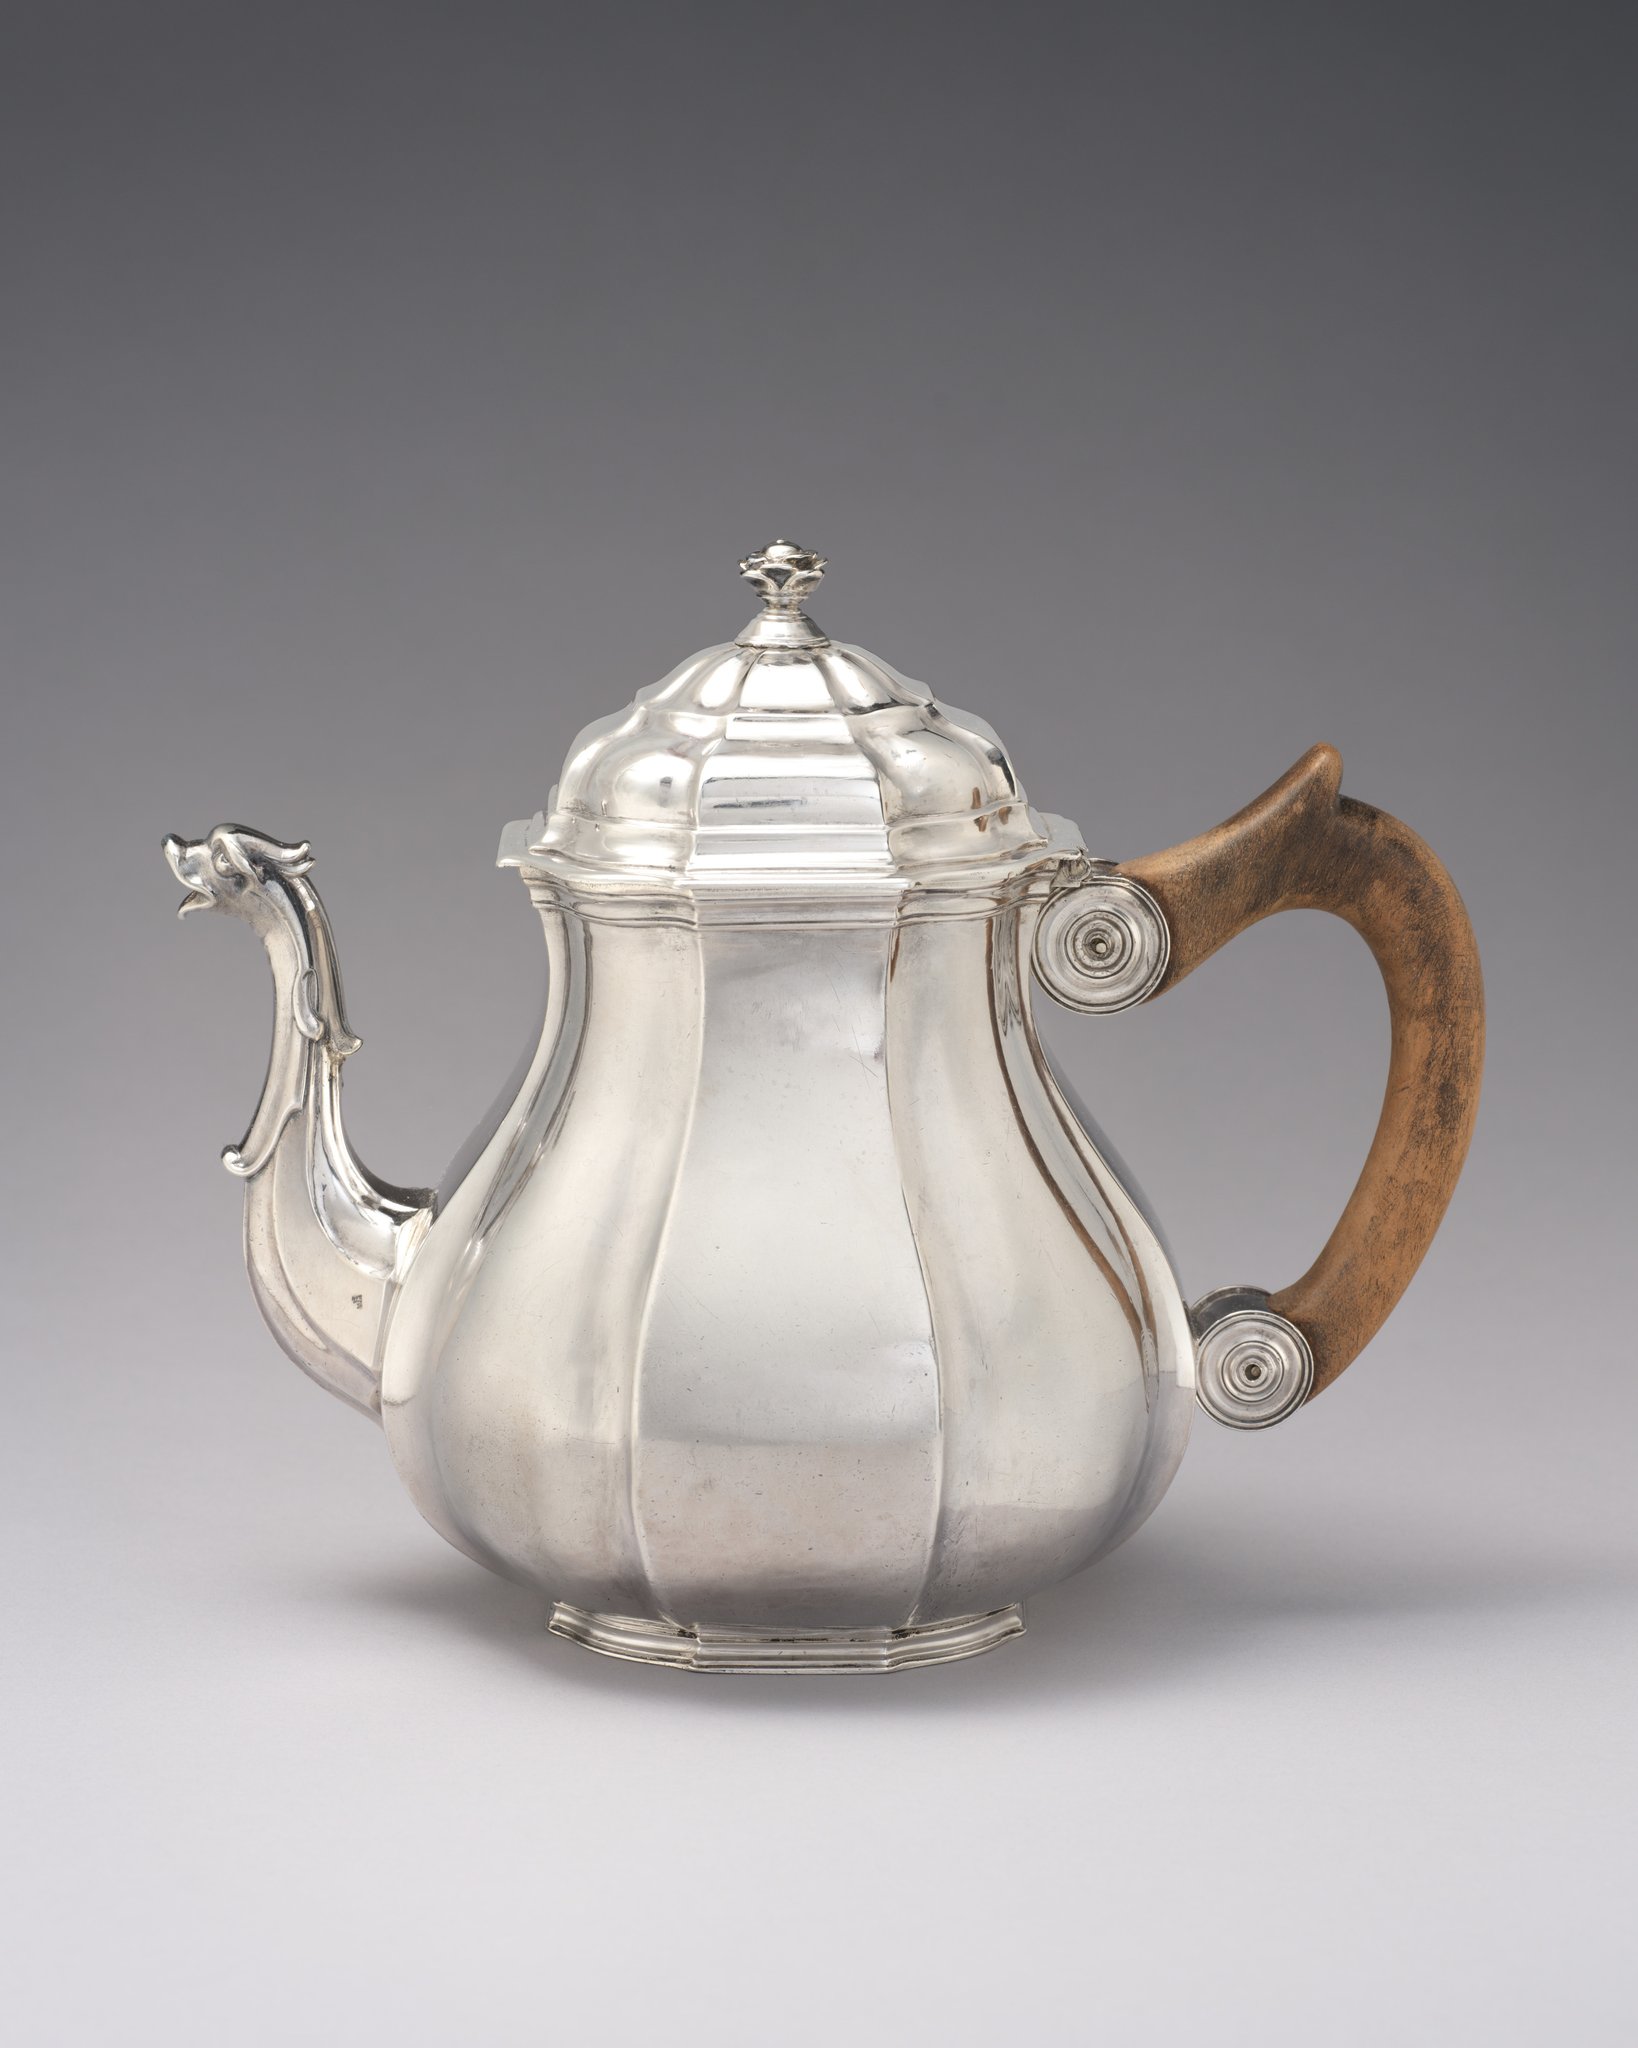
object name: teapot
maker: jean-martin winoc du moulin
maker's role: maker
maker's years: 1727-1766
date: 1753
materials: silver, wood